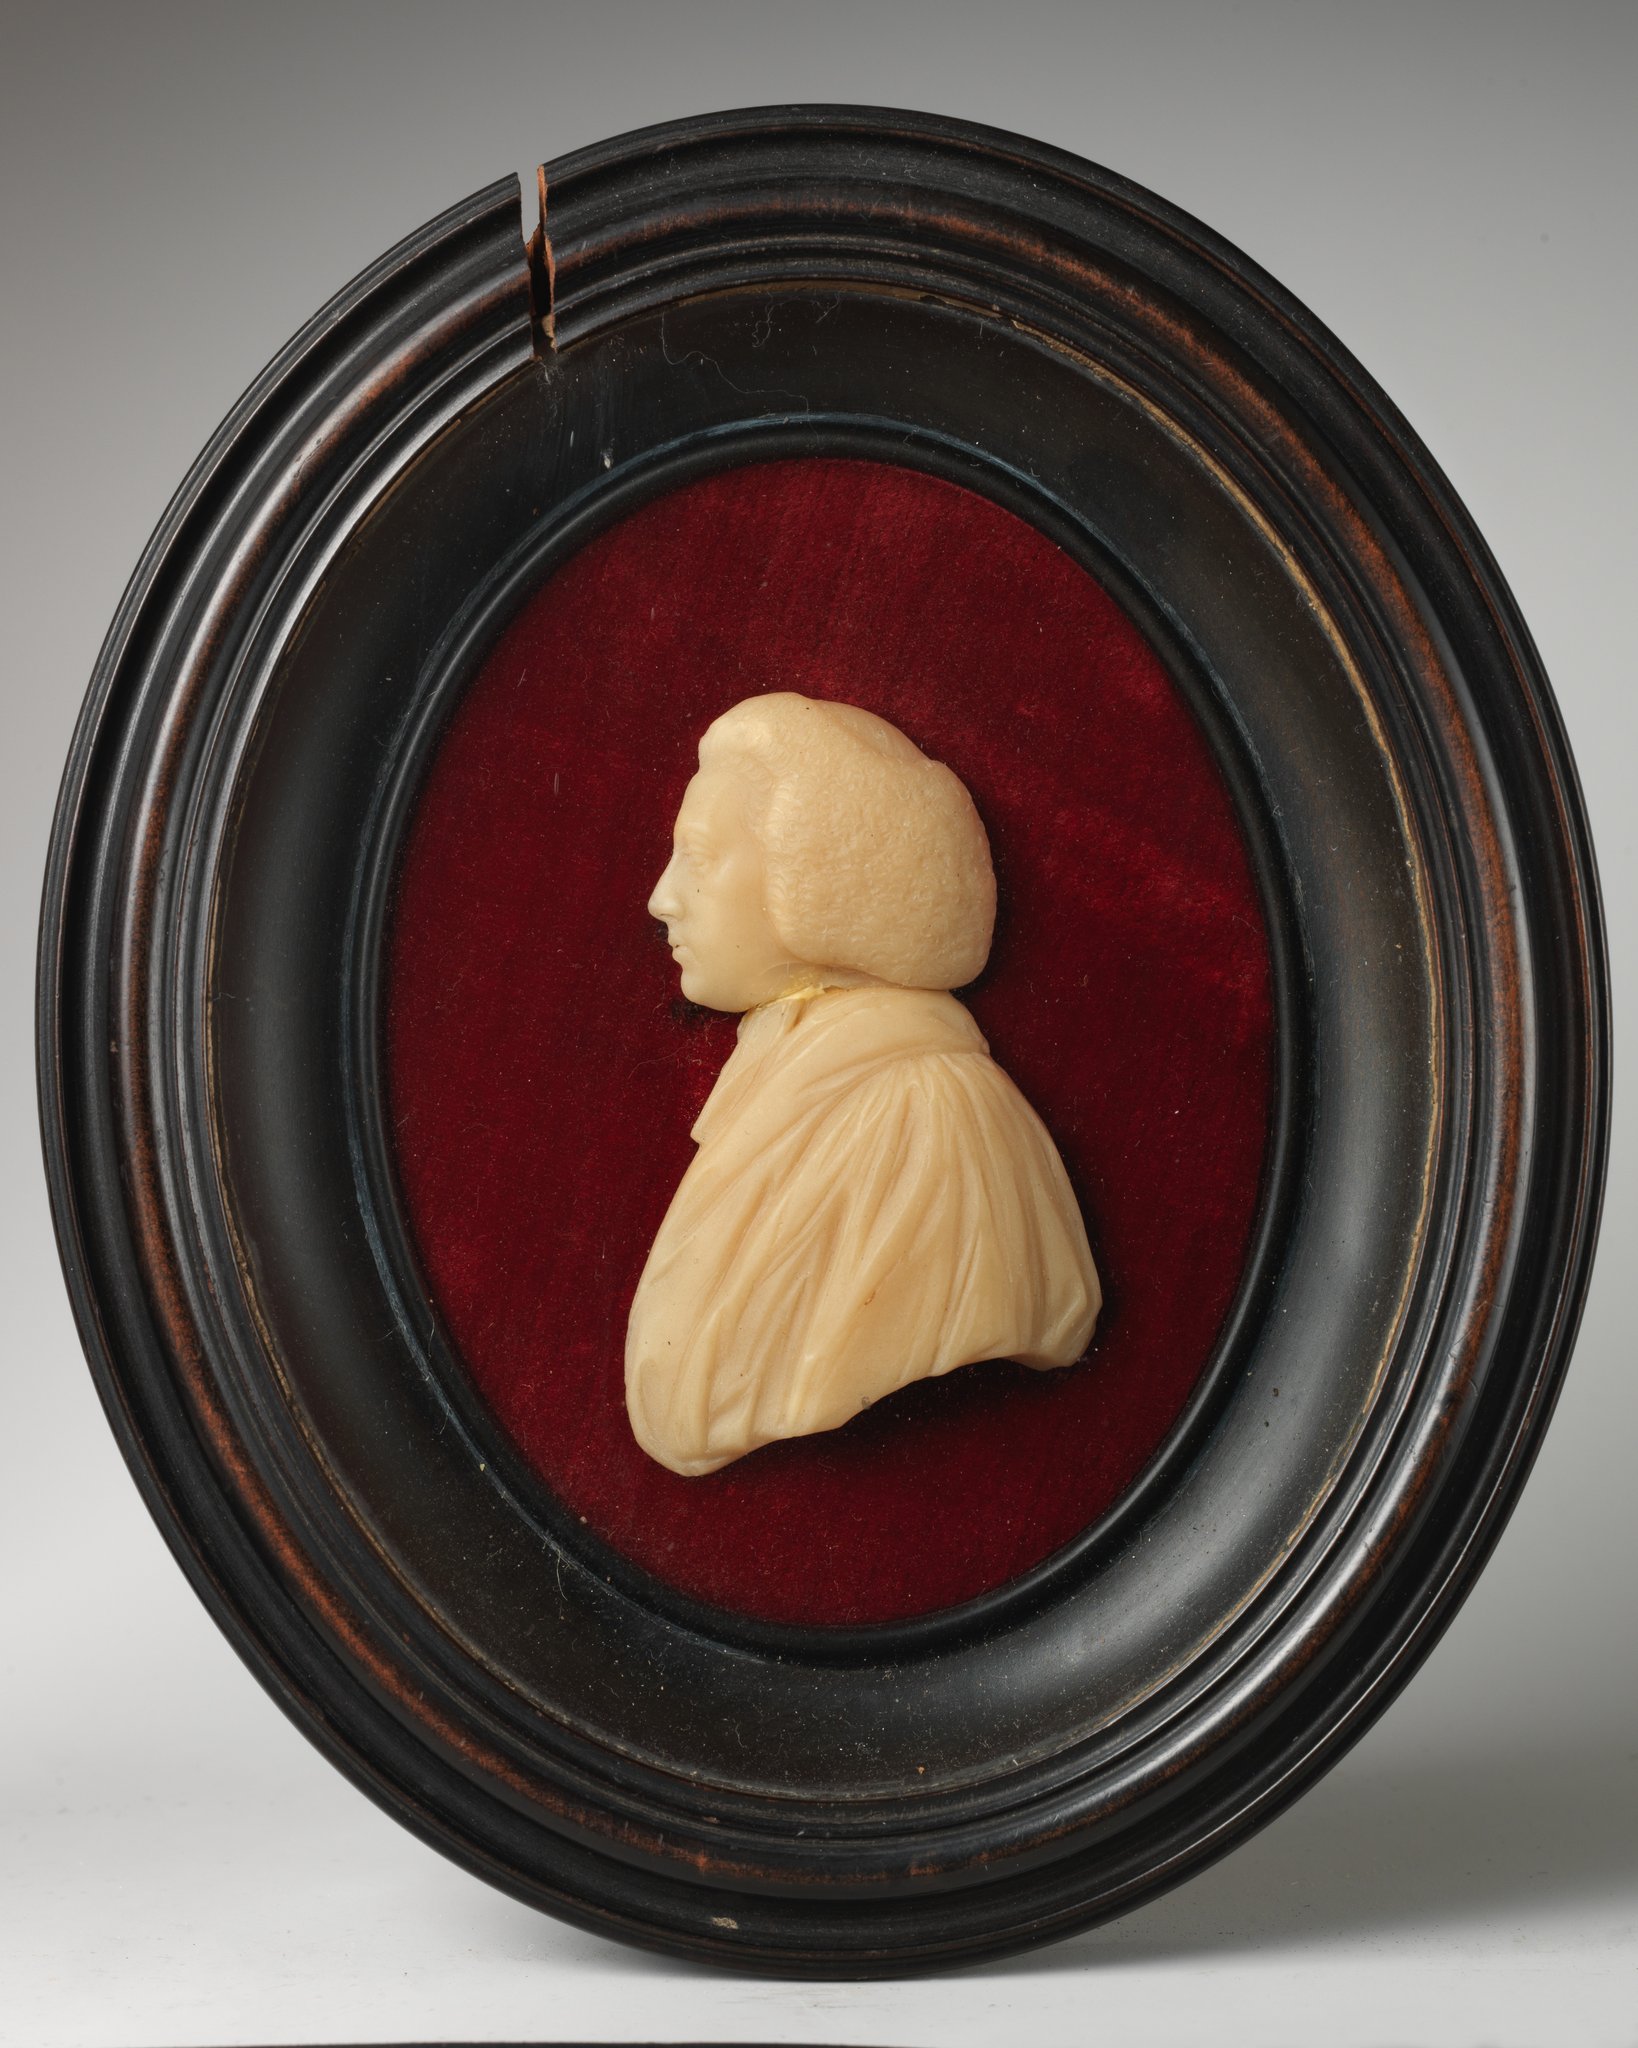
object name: medallion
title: Member of the Willoughby de Broke Family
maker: isaac gosset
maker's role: artist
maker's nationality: british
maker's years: 1713-1799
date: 1701-1800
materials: glass, velvet, wax, wood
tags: men,profiles